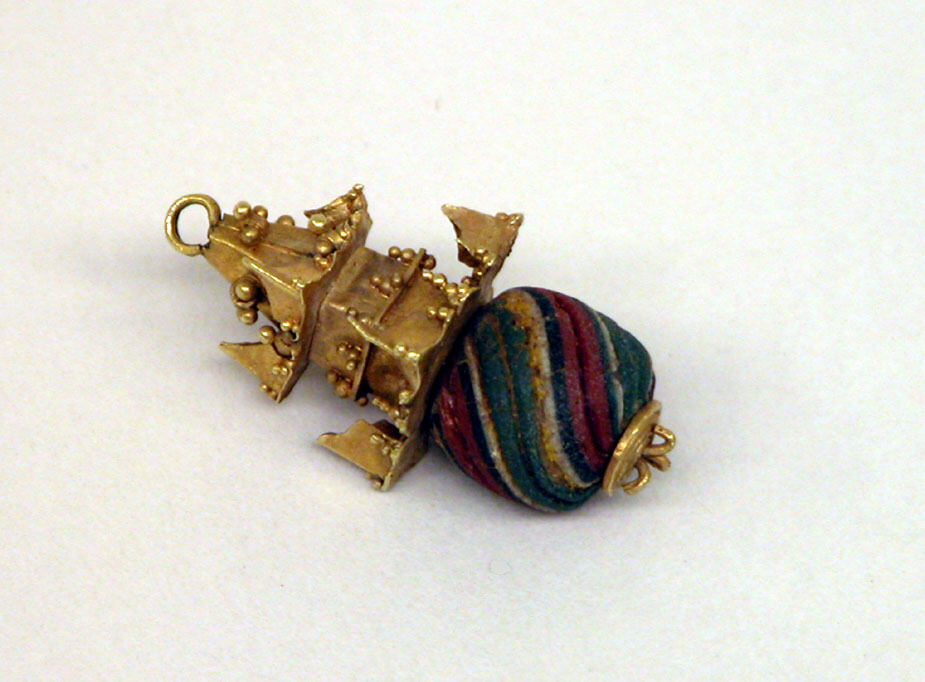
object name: pendant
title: Pendant with Striated Multicolored Bead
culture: indonesian, javanese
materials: gold